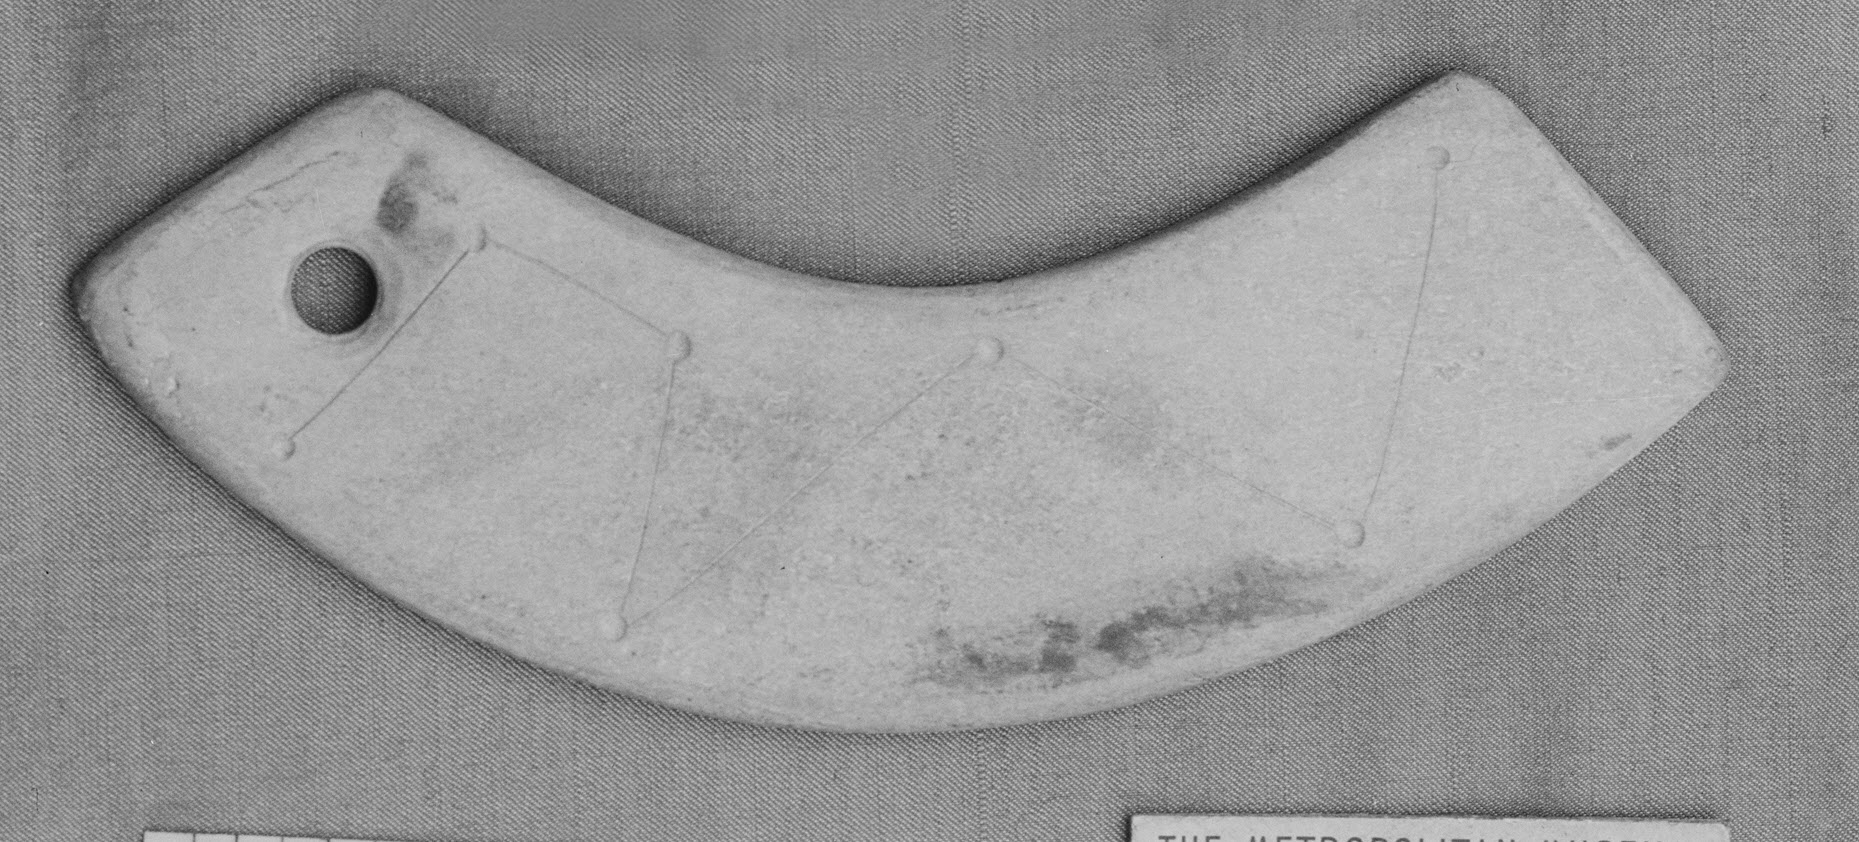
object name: emblem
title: Huang: Emblem of the North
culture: chinese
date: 206 BCE-250 CE